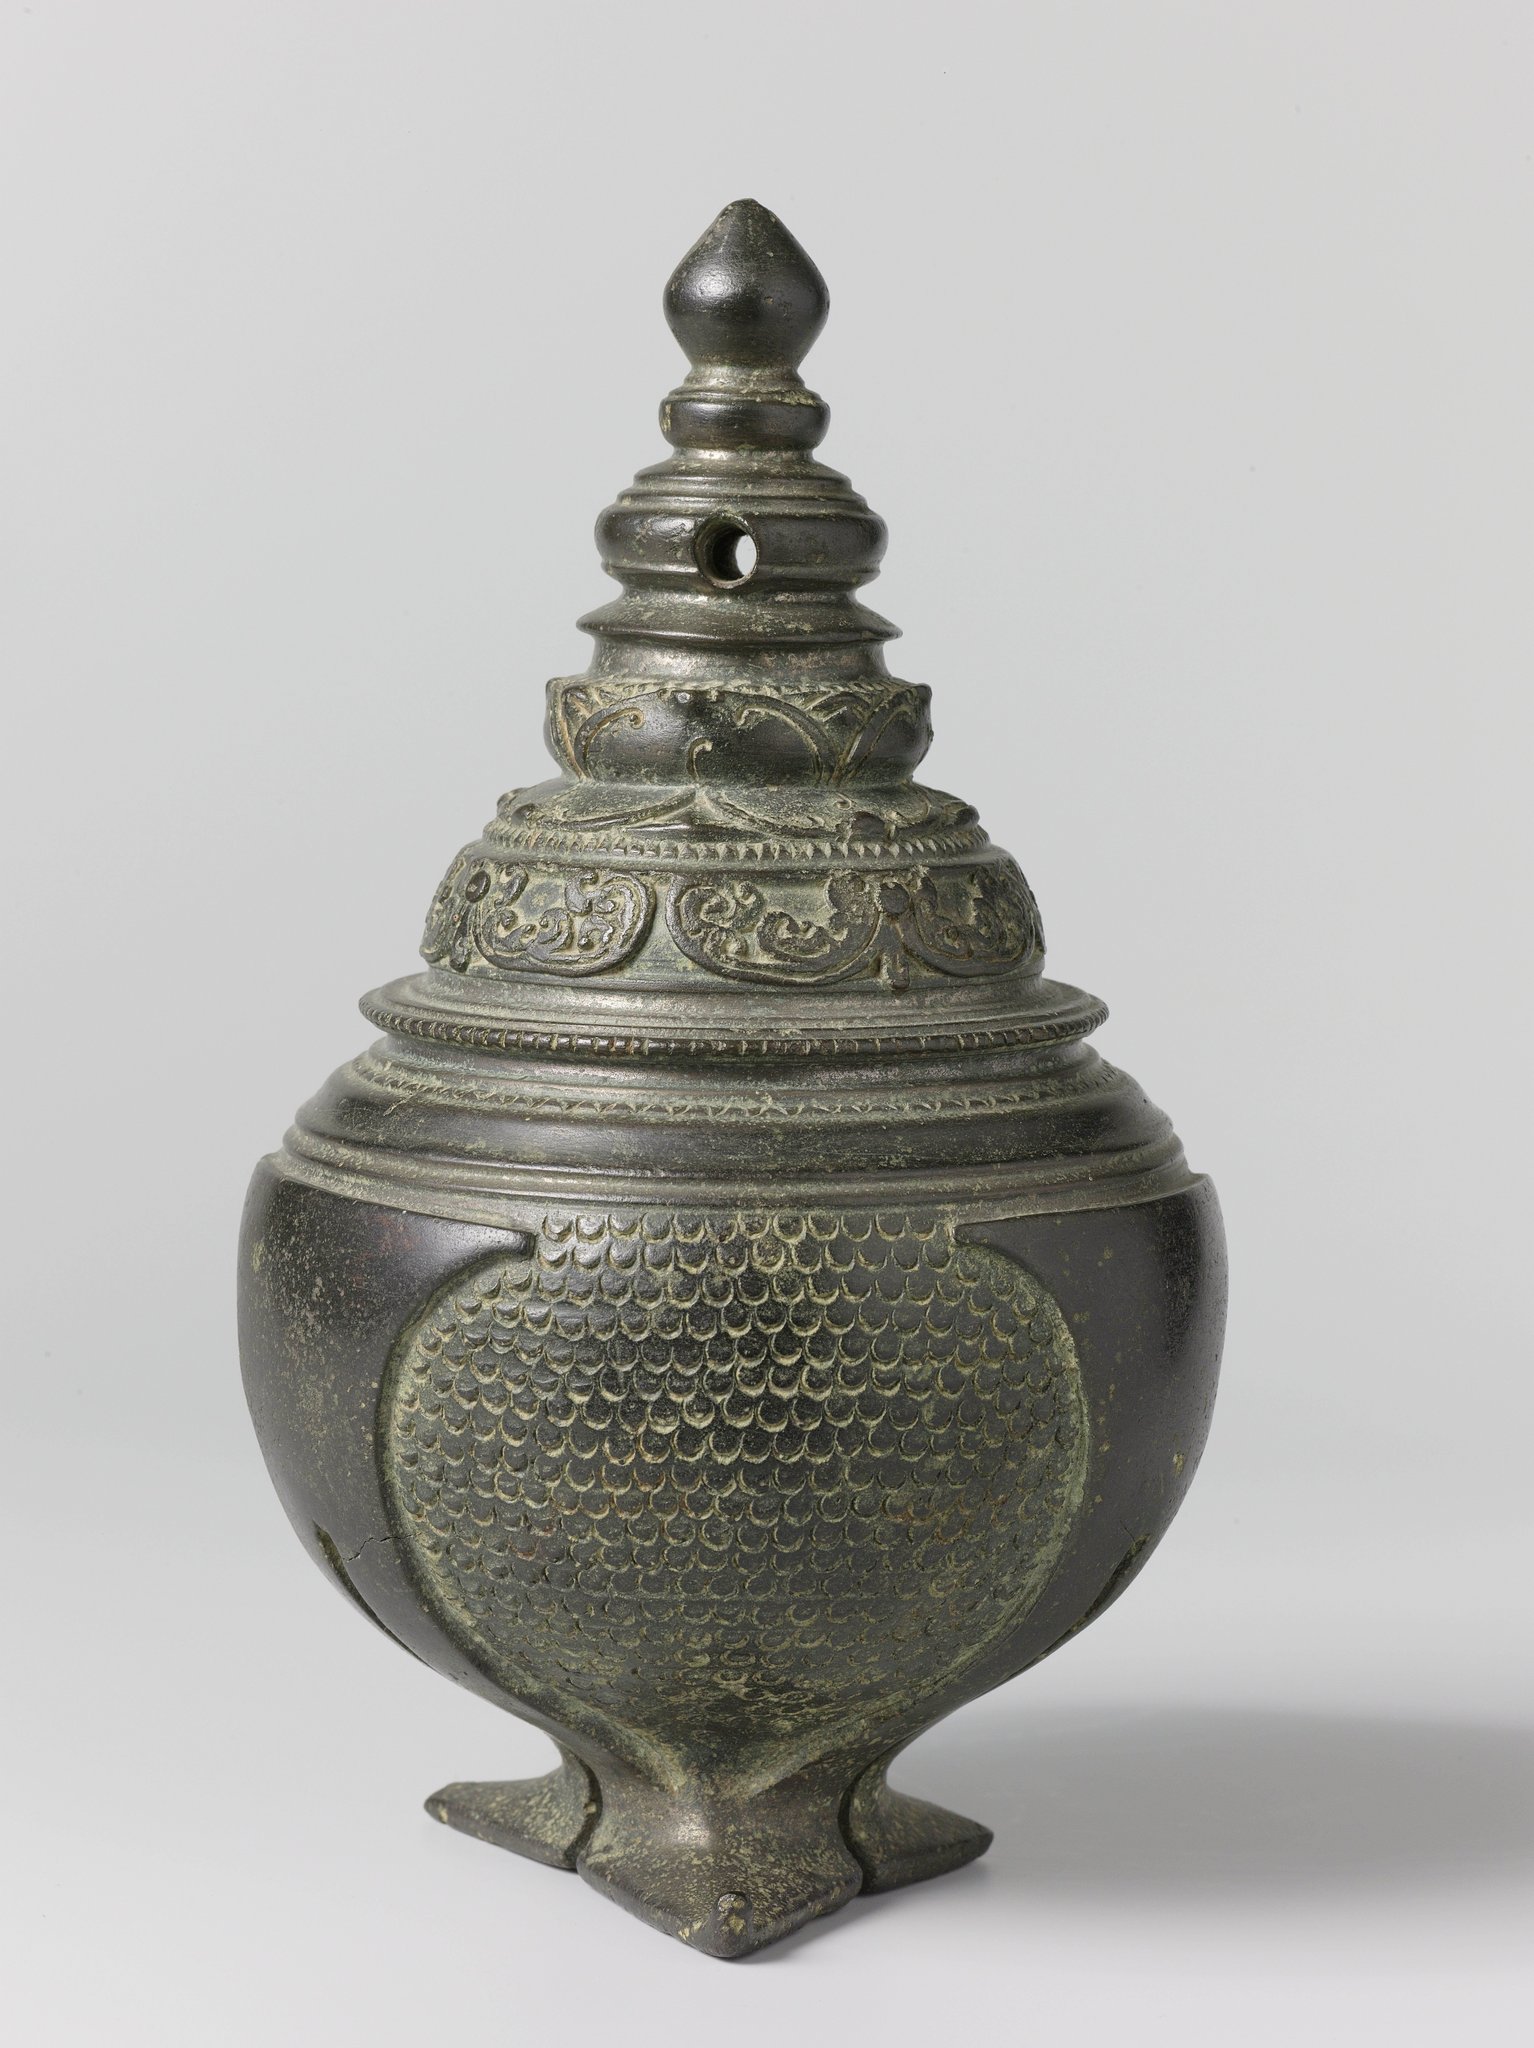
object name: vessel rattle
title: Bell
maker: Anonymous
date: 930-1500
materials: bronze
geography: indonesia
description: Sound is crucial in Hindu Buddhist rituals. It attracts attention, fosters concentration, and purifies the environment. A loose ball inside the bell, standing on a triangular base, rings when it is moved.